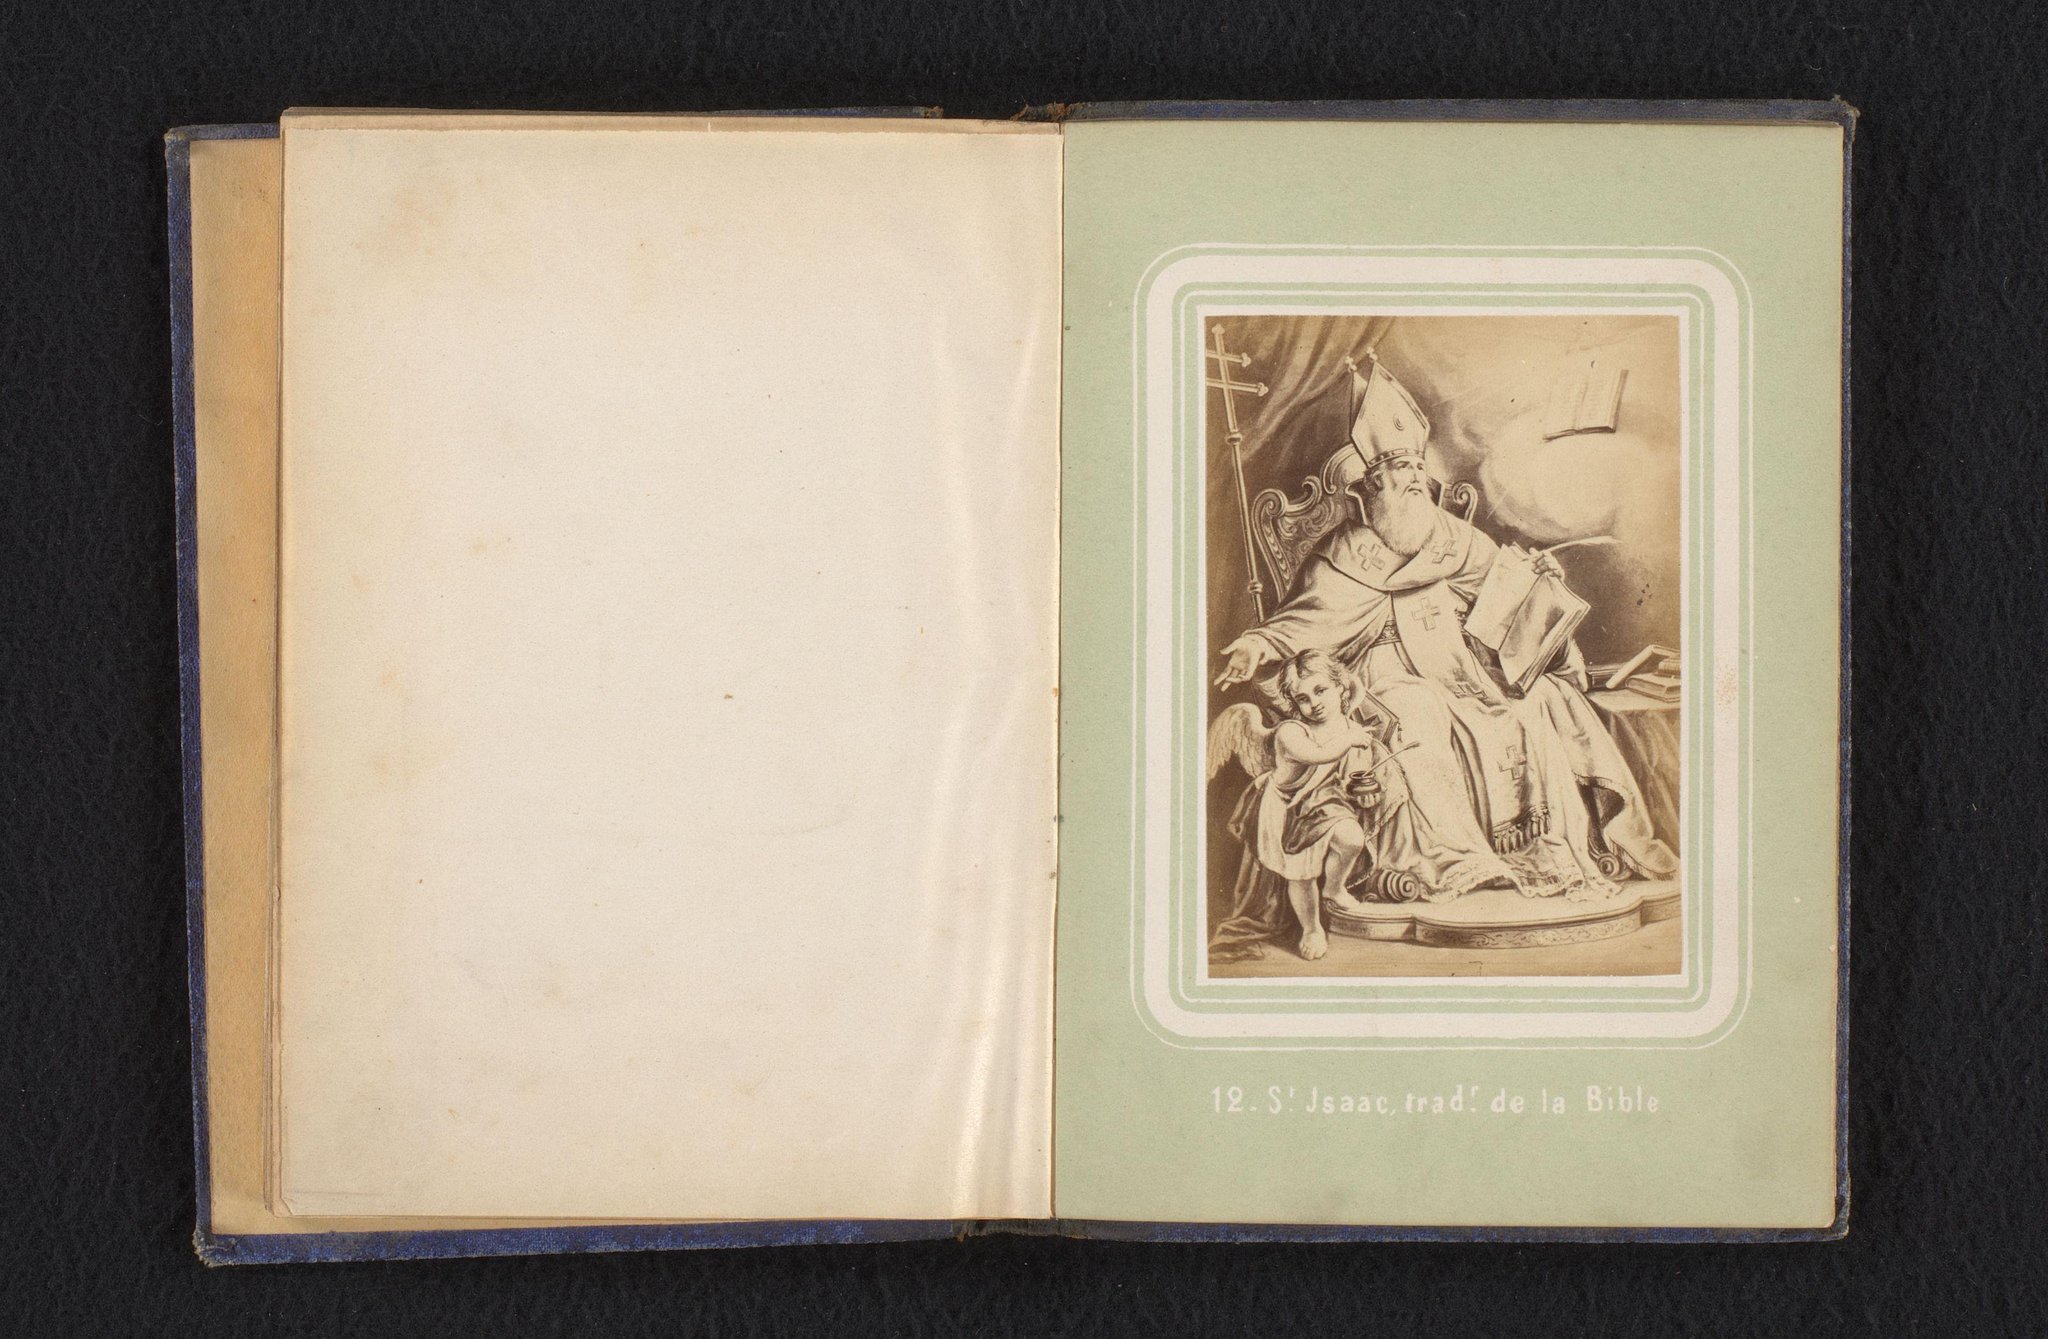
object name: reproduction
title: Fotoreproductie van een tekening van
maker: Anonymous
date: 1870-1890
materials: paper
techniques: albumen print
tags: anonymous historical person portrayed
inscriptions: number: ‘12.’